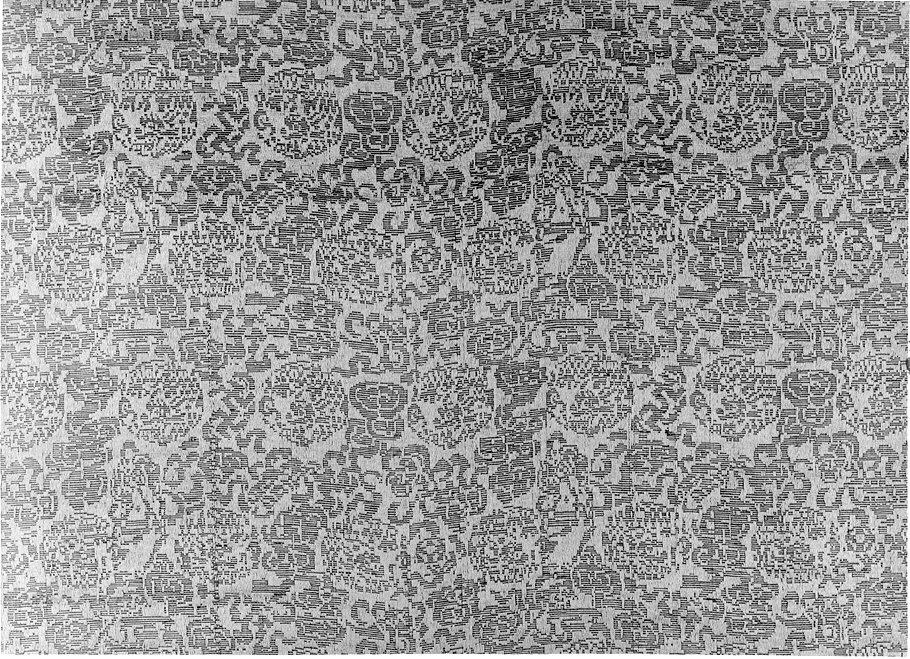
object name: length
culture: chinese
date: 1867-1933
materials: silk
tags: dragons